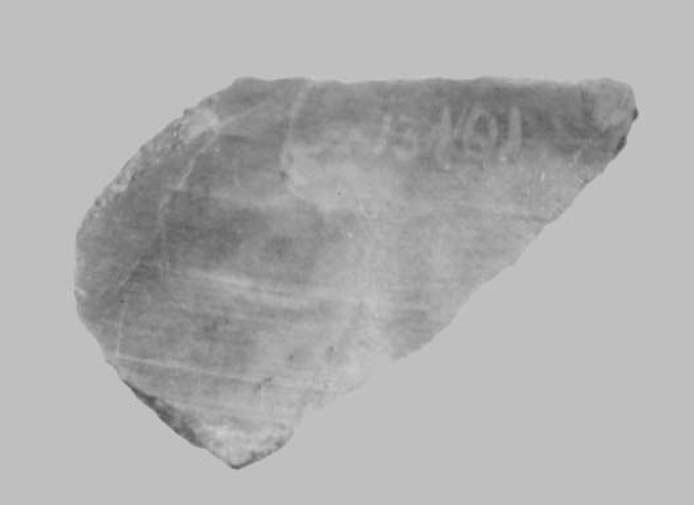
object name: fragment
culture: russian, siberia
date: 1902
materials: jade